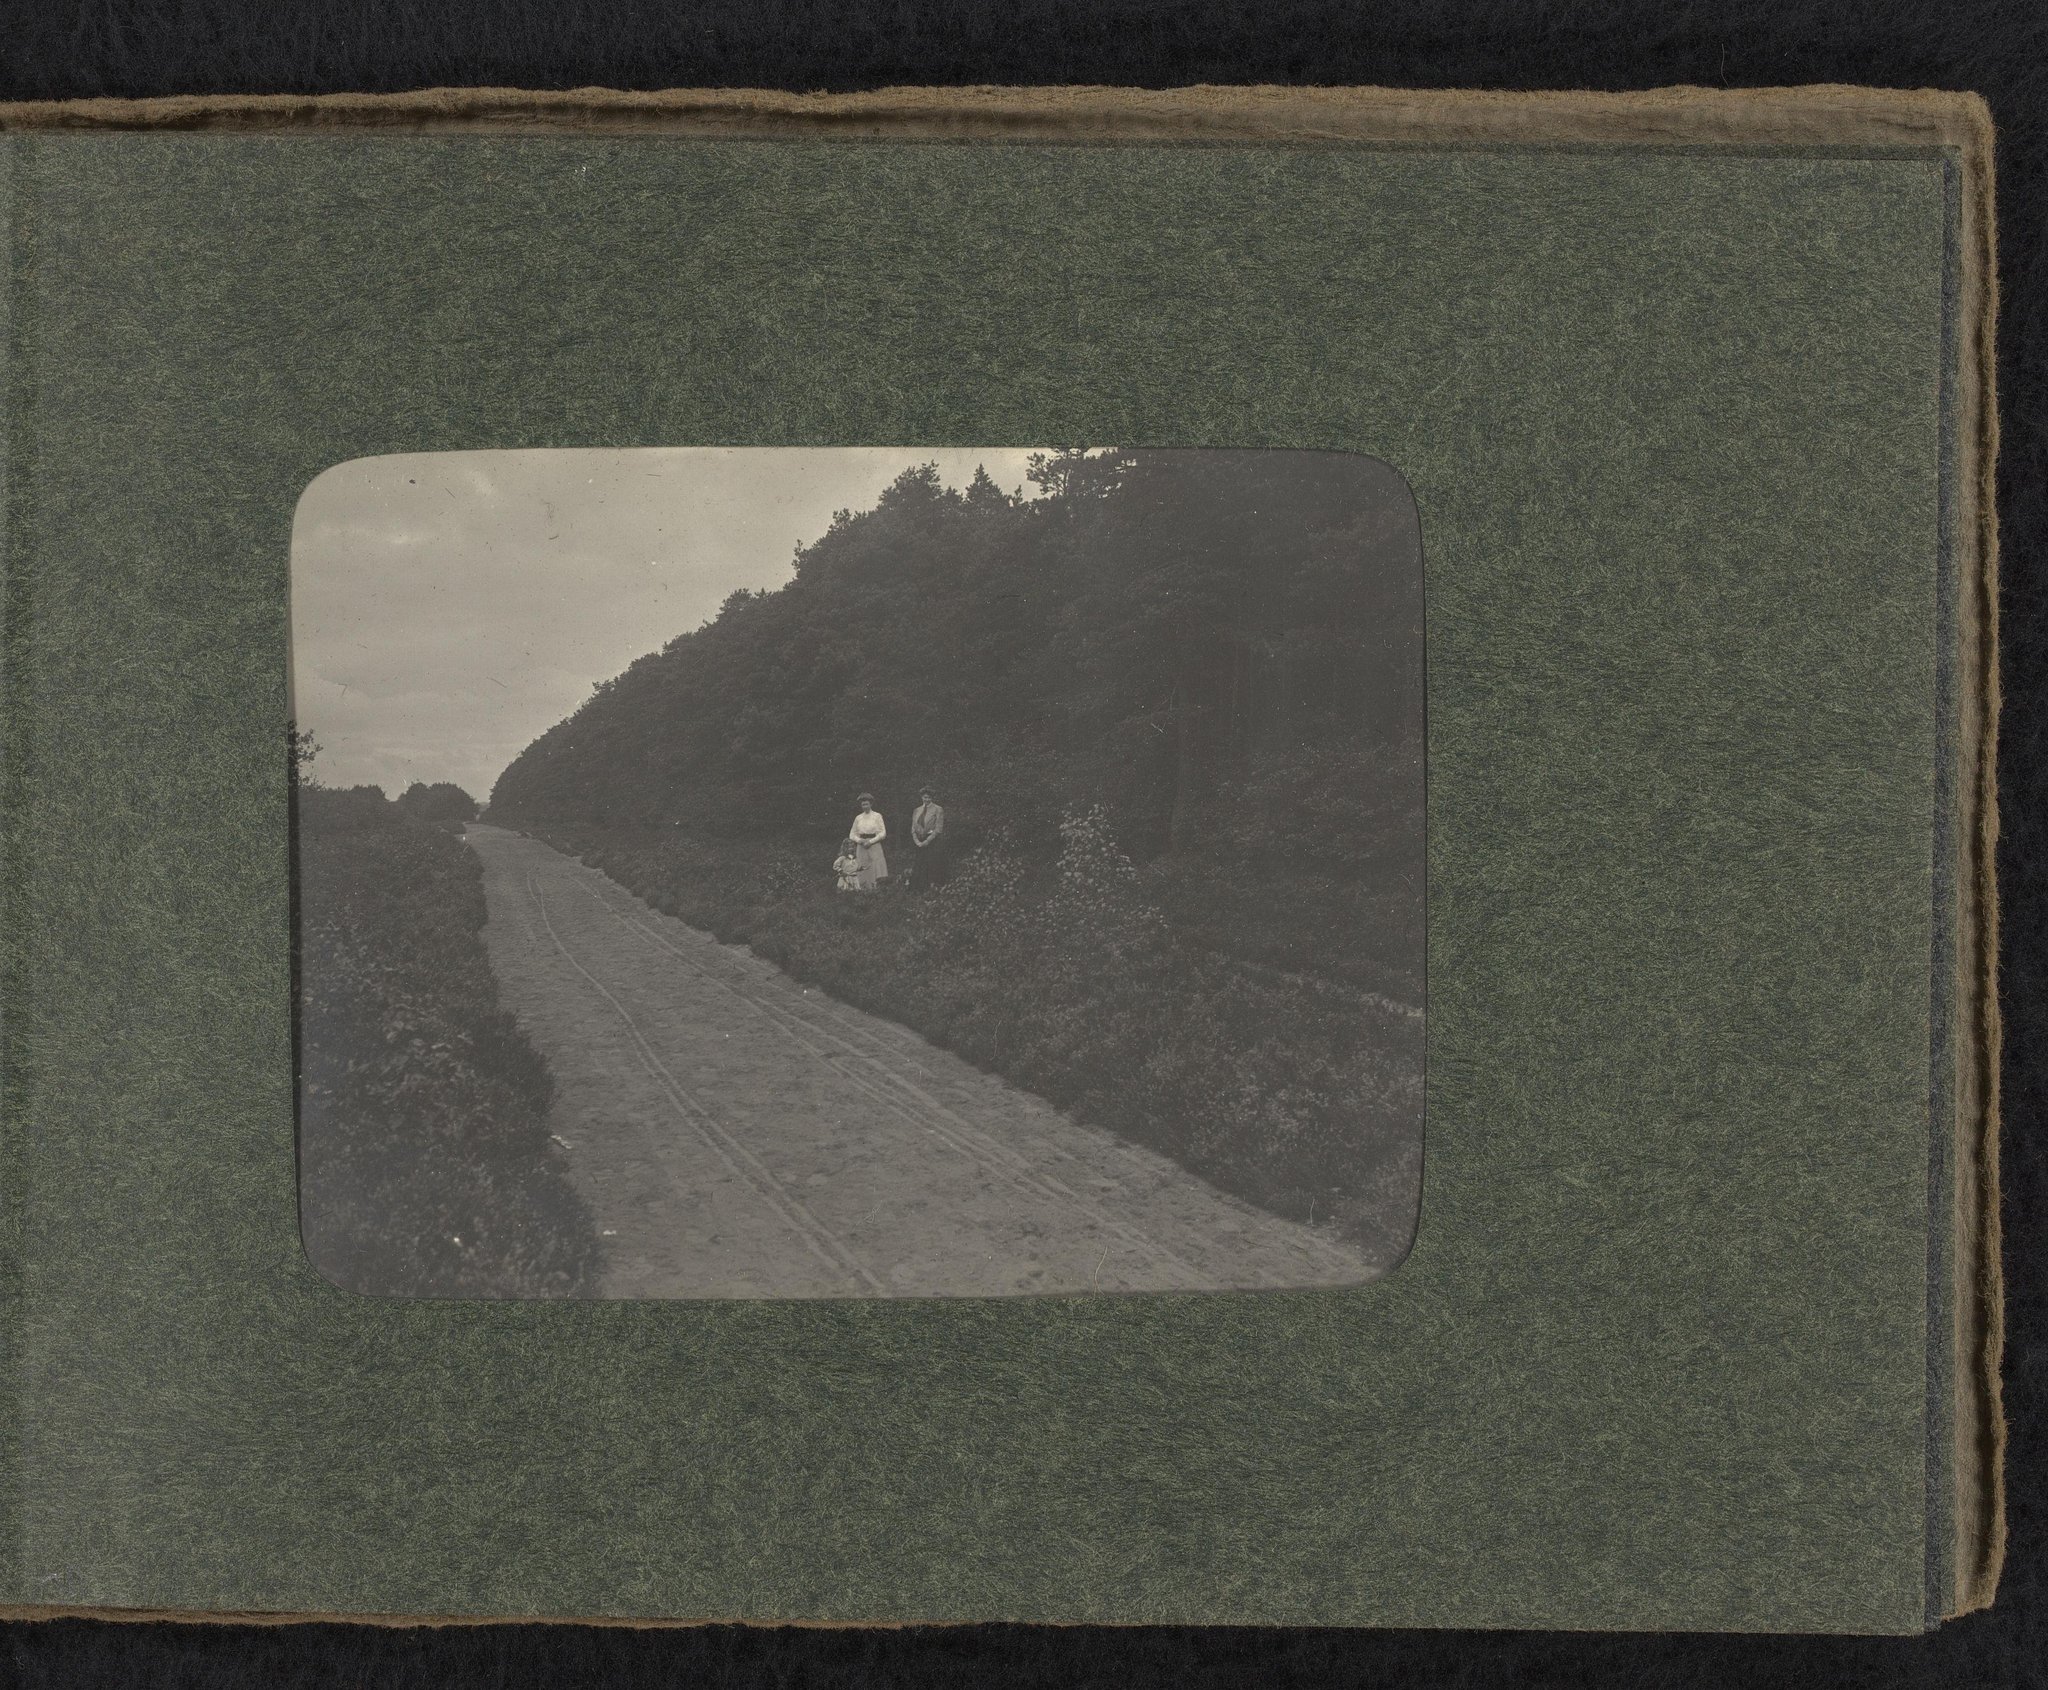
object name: photograph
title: Drie leden van de familie van den Berg met hond, langs een landweg op de heide in Huis ter Heide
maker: hendrik herman van den berg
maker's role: amateurfotograaf, jurist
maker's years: 1875-1944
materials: paper, cardboard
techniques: gelatin silver print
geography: huis ter heide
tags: the hague, caroline louise van den berg-van den berg, family life, dog